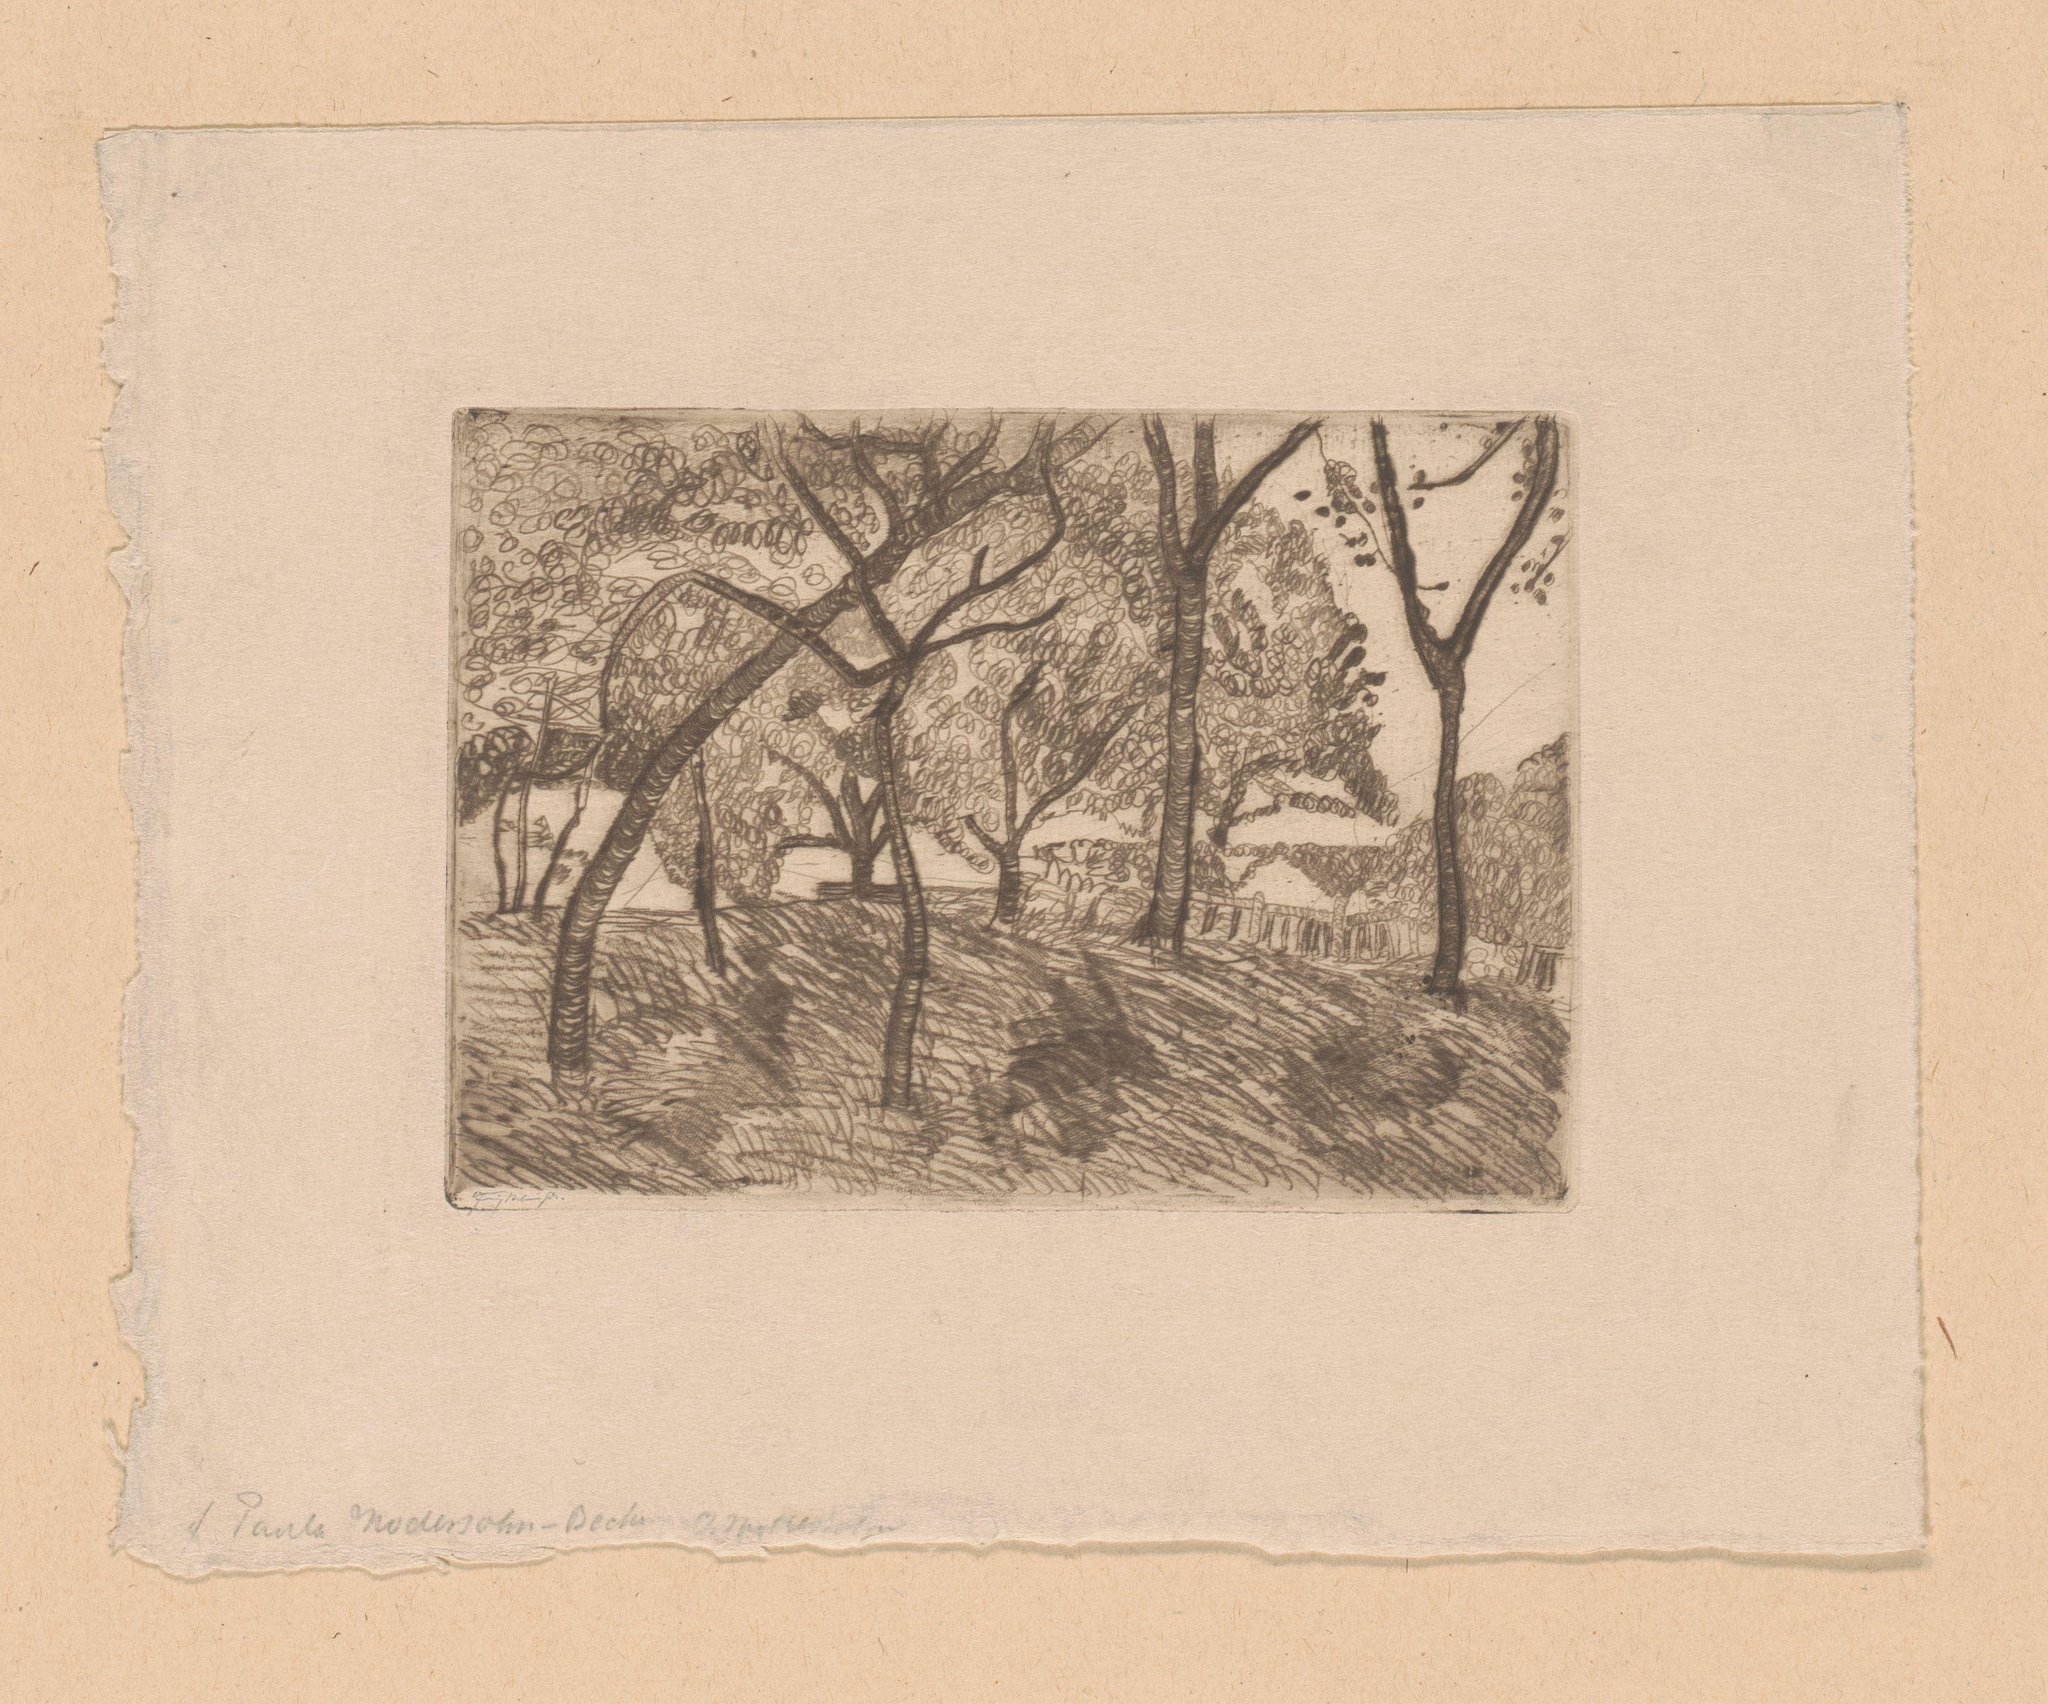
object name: print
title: Bosgezicht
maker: paula modersohn-becker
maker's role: print maker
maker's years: 1876-1907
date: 1886-1907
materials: paper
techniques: drypoint, etching, roulette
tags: forest, wood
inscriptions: collector's mark: Lugt 2228